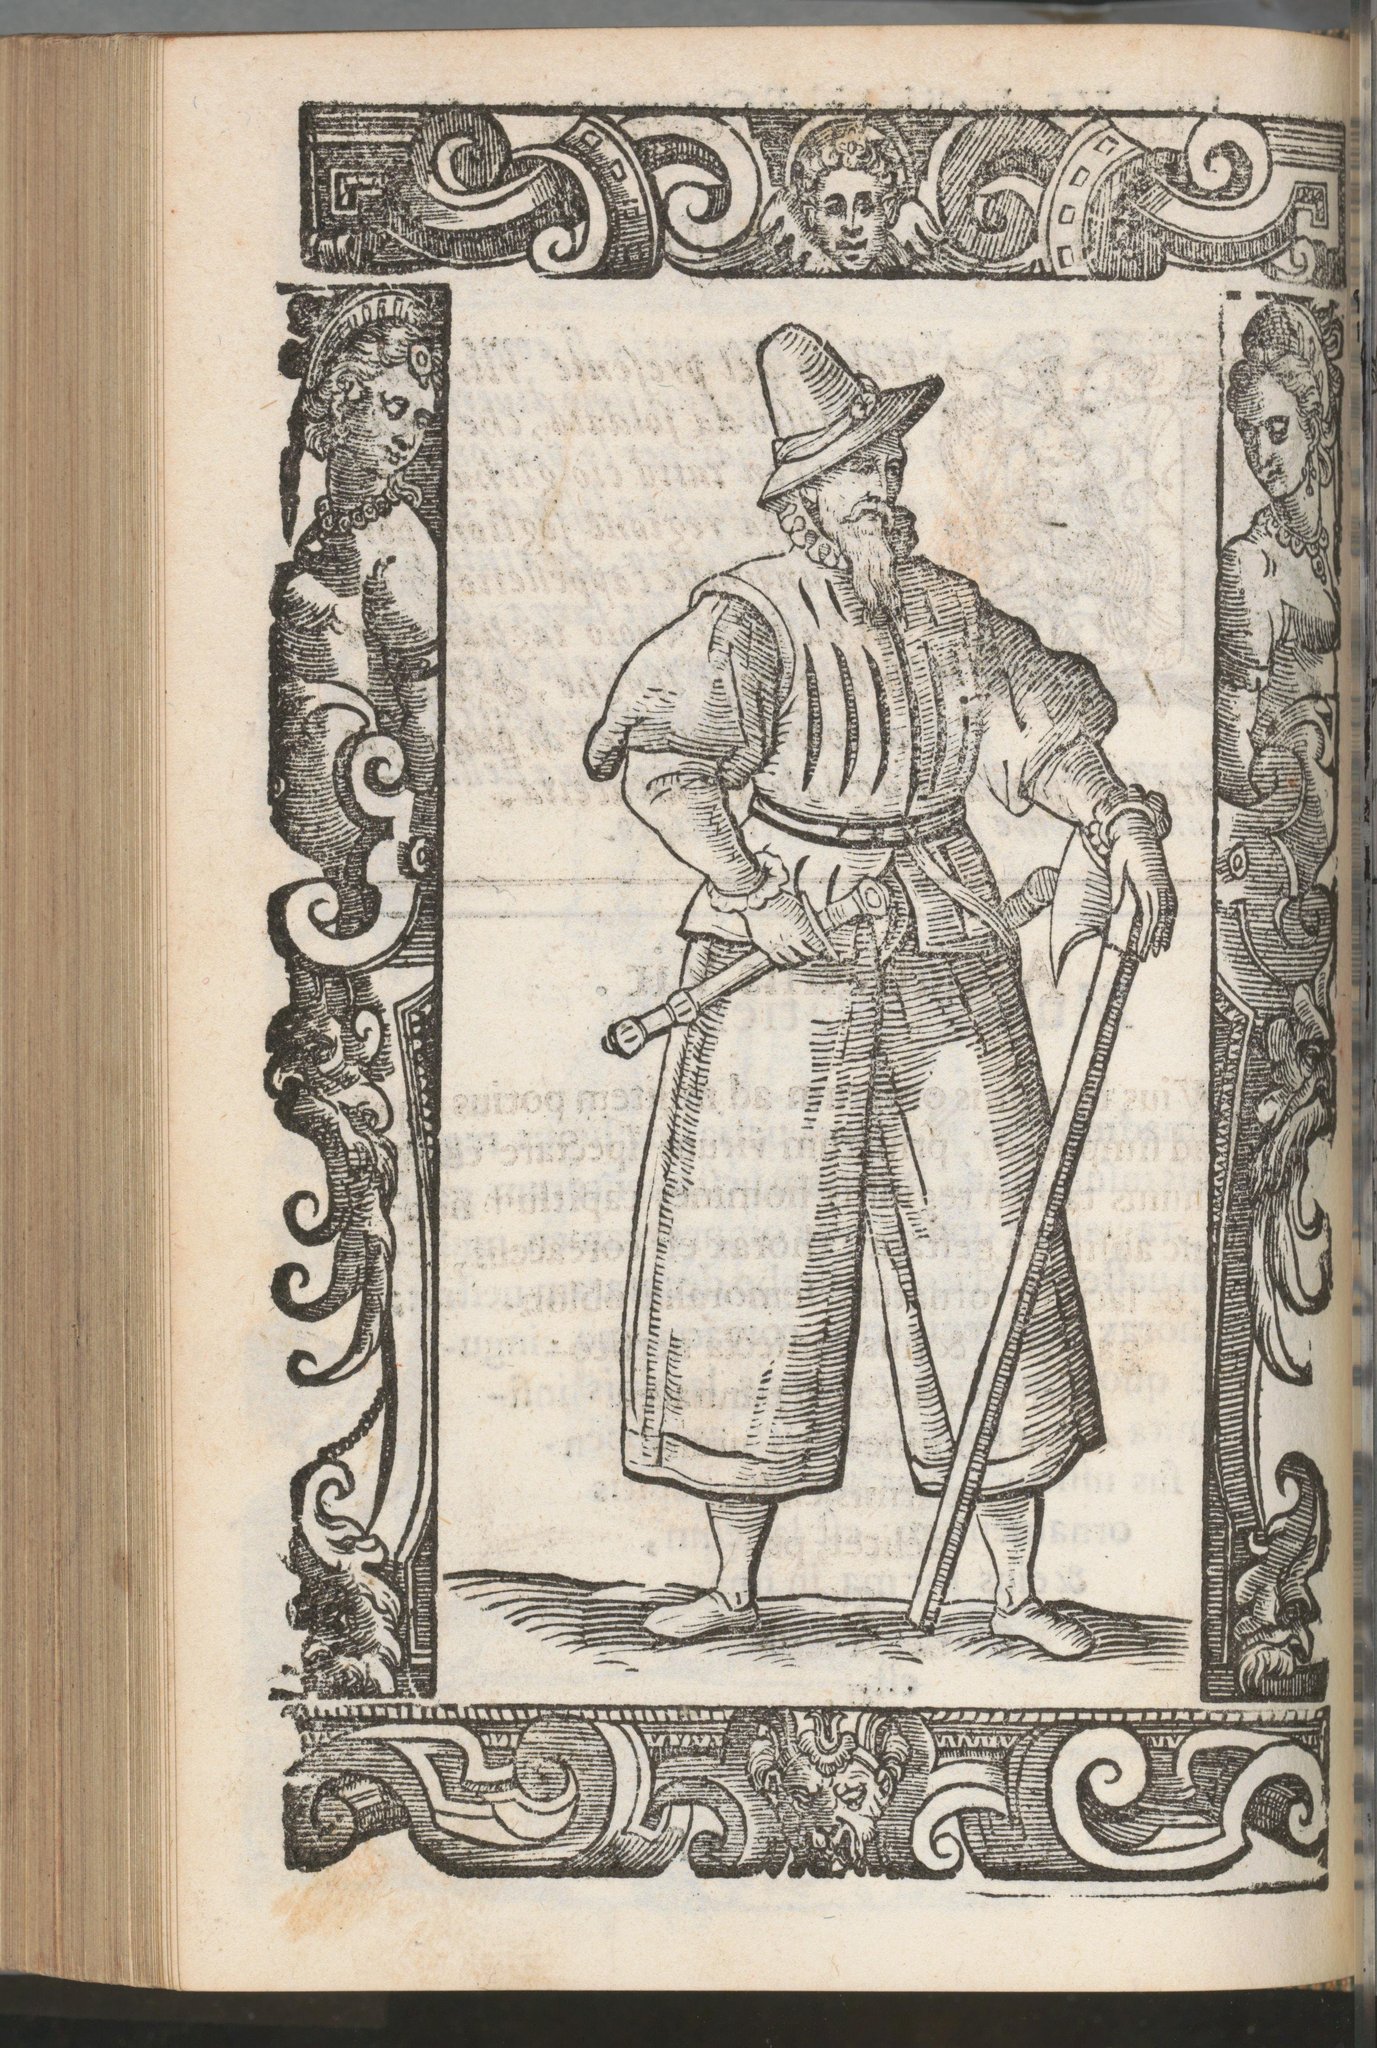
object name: costume print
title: Habiti antichi, et moderni di tutto il mondo...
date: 1598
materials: paper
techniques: woodcut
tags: fashion plates